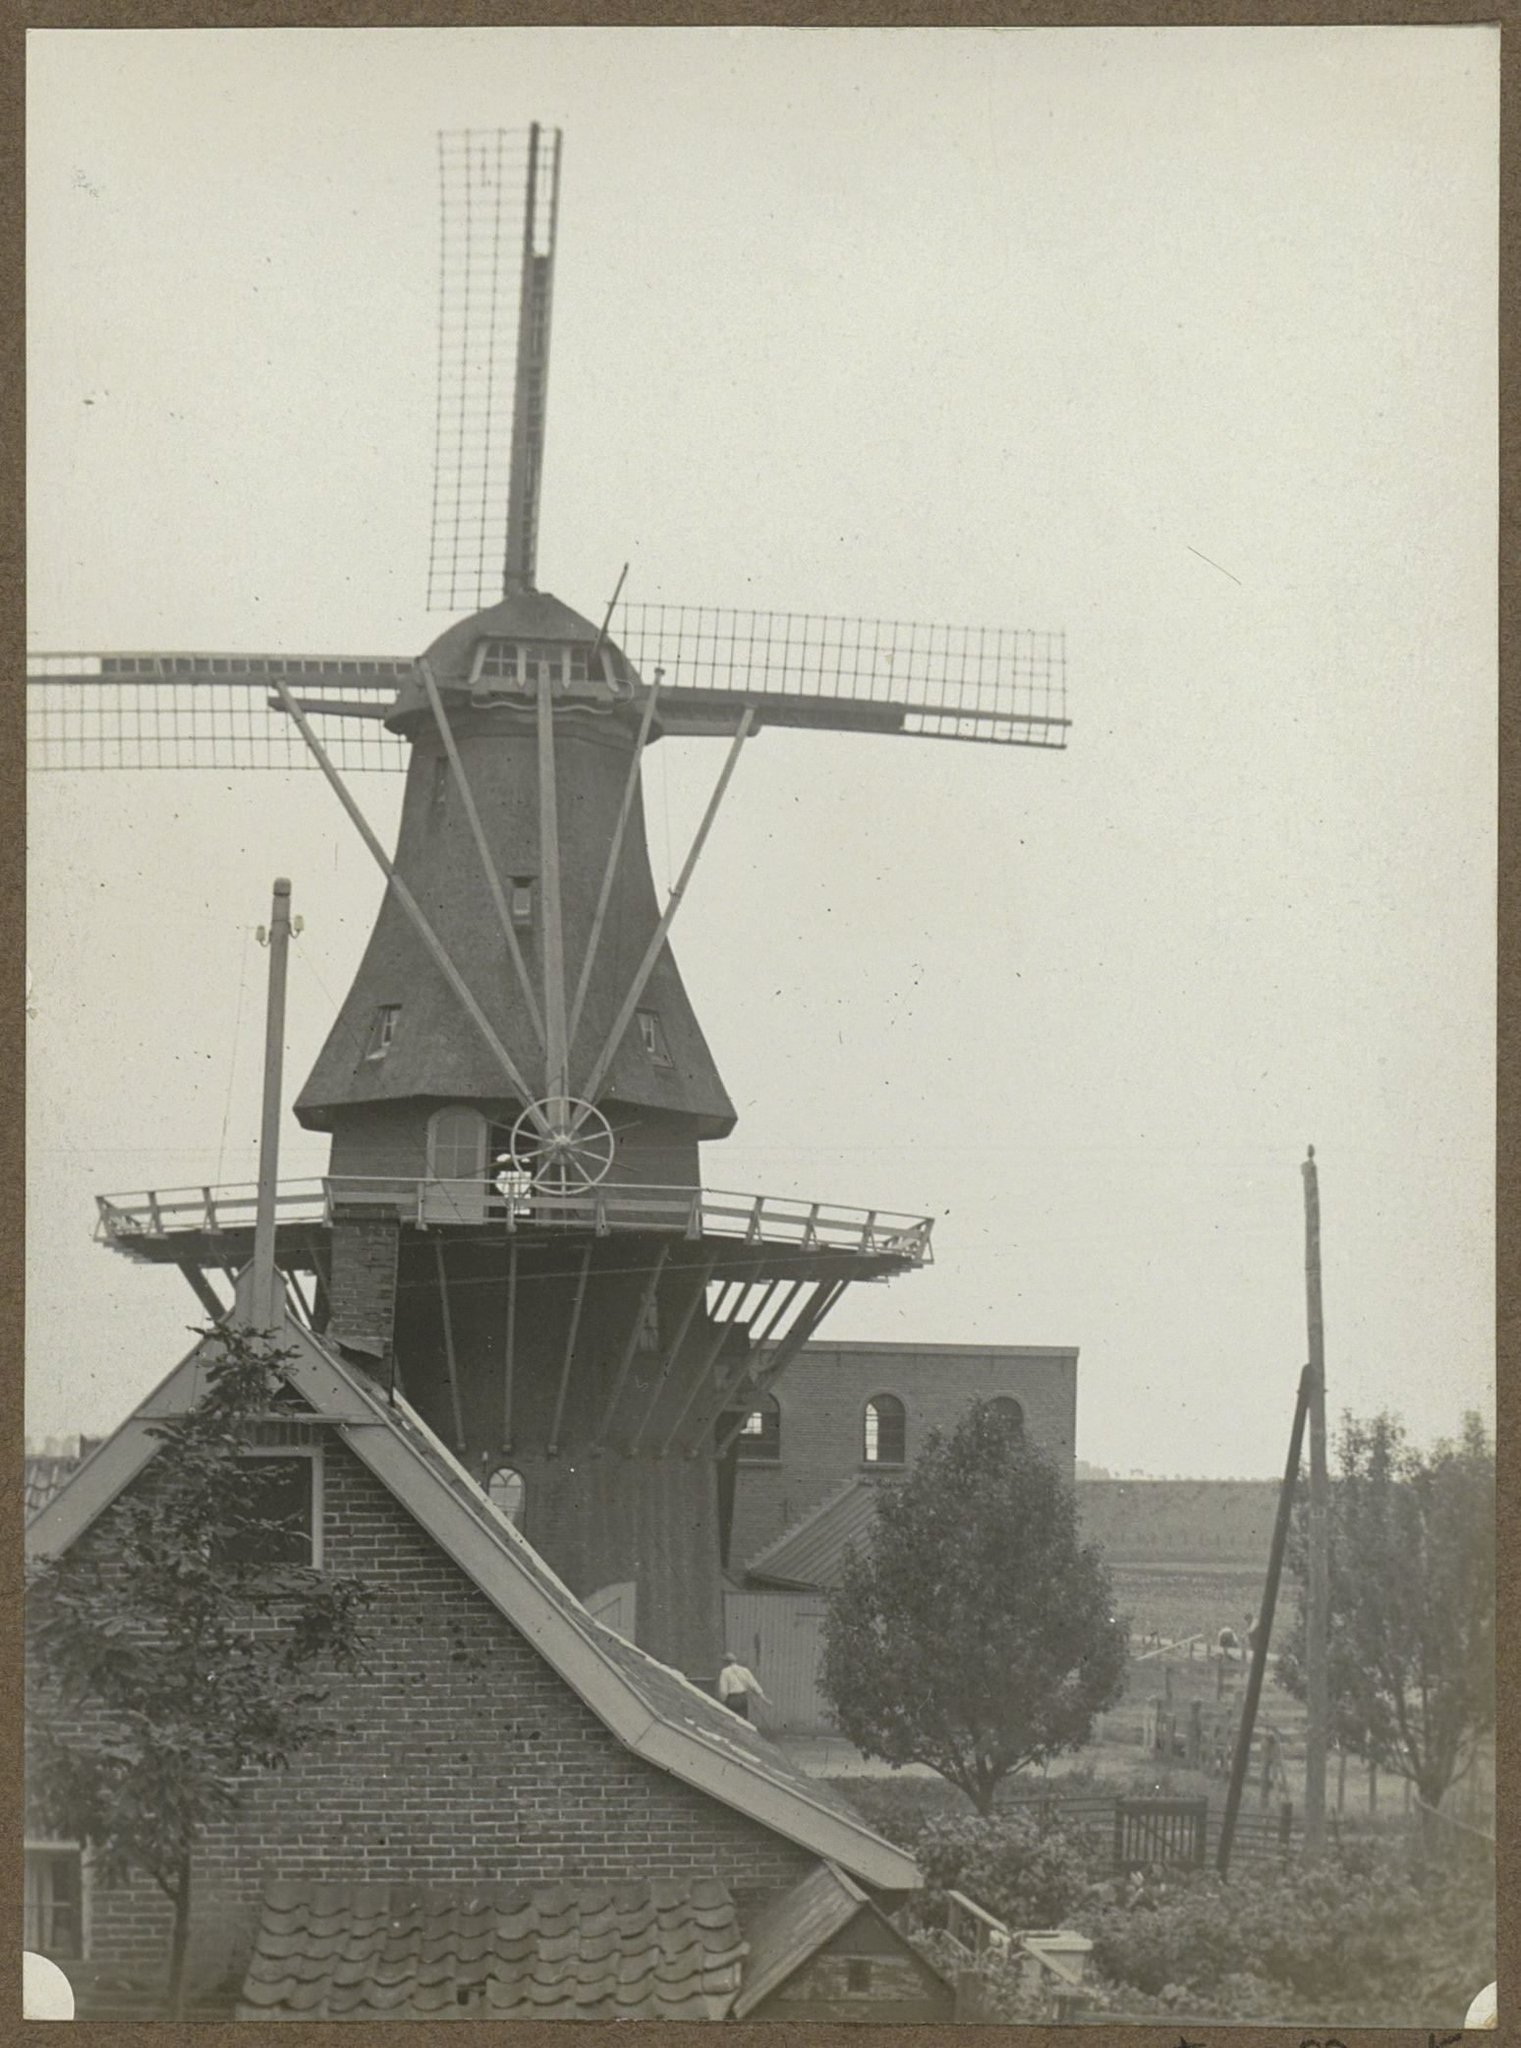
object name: photograph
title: Windmolen in de Haarlemmermeer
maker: Anonymous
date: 1900-1915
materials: paper, photographic support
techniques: gelatin silver print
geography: haarlemmermeer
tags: windmill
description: Onderdeel van Album met foto's van Amsterdam en omgeving.